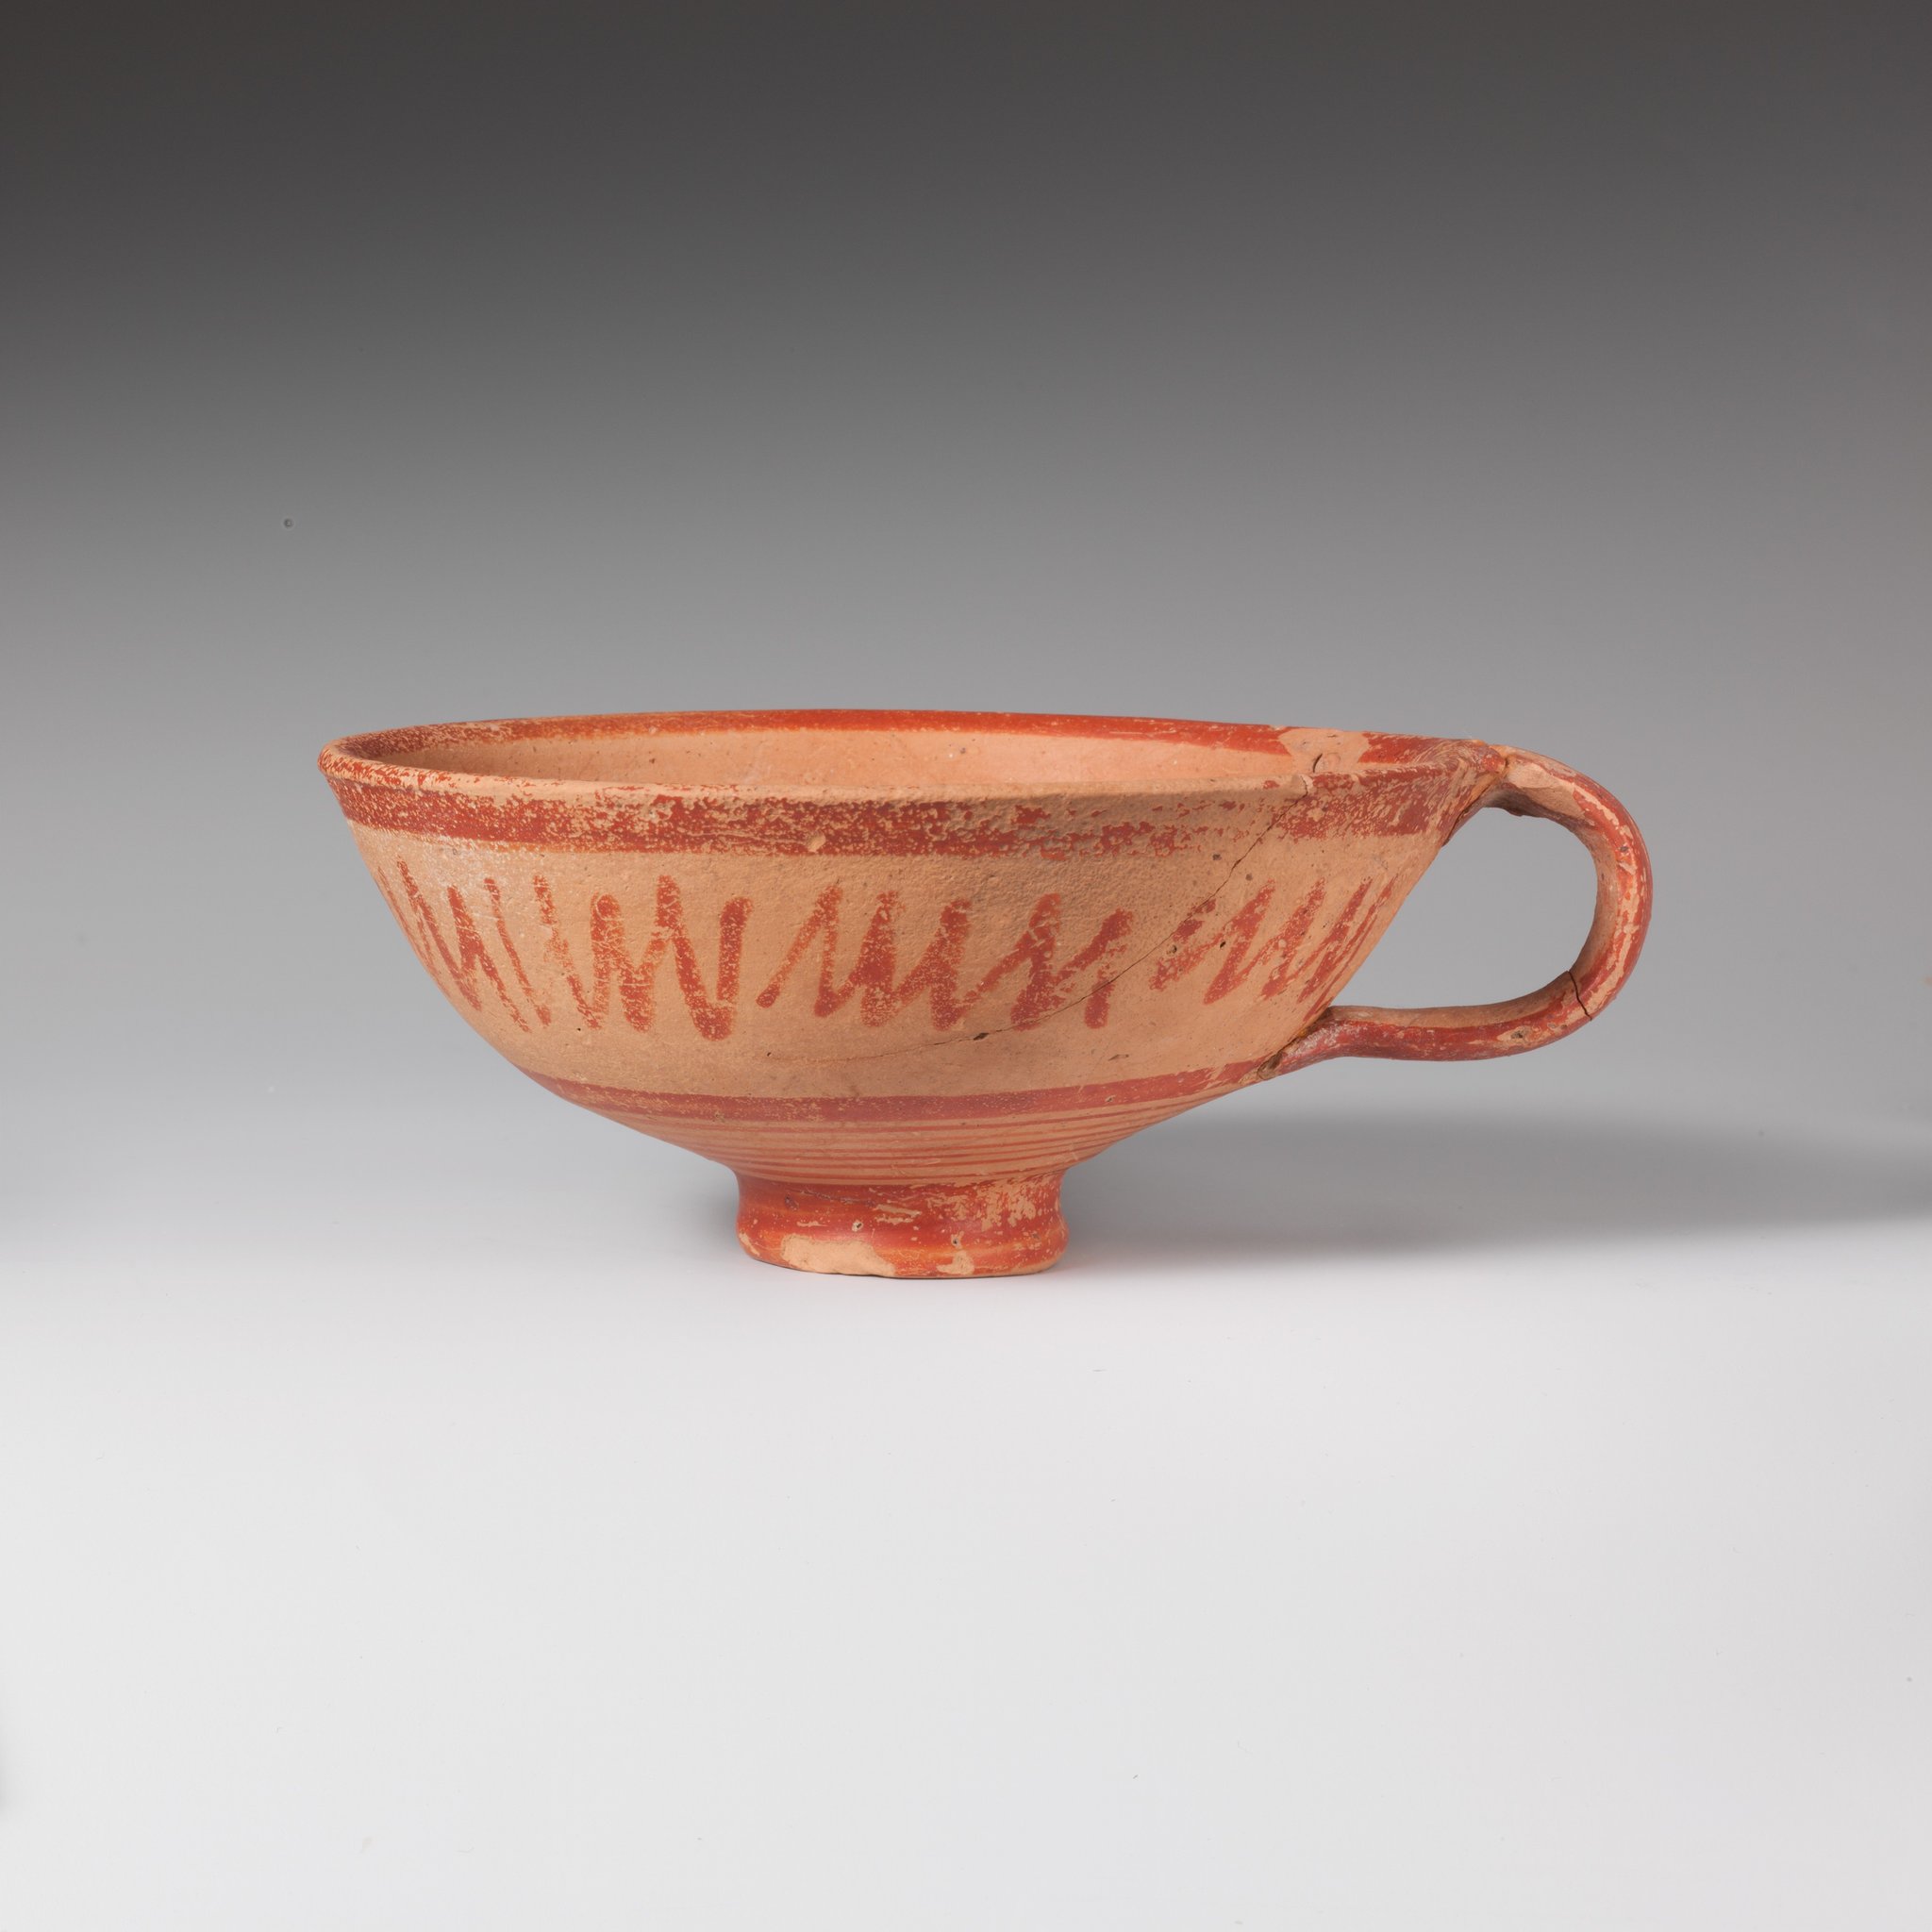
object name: cup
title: Terracotta cup with one handle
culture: mycenaean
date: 1600-1050 BCE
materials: terracotta